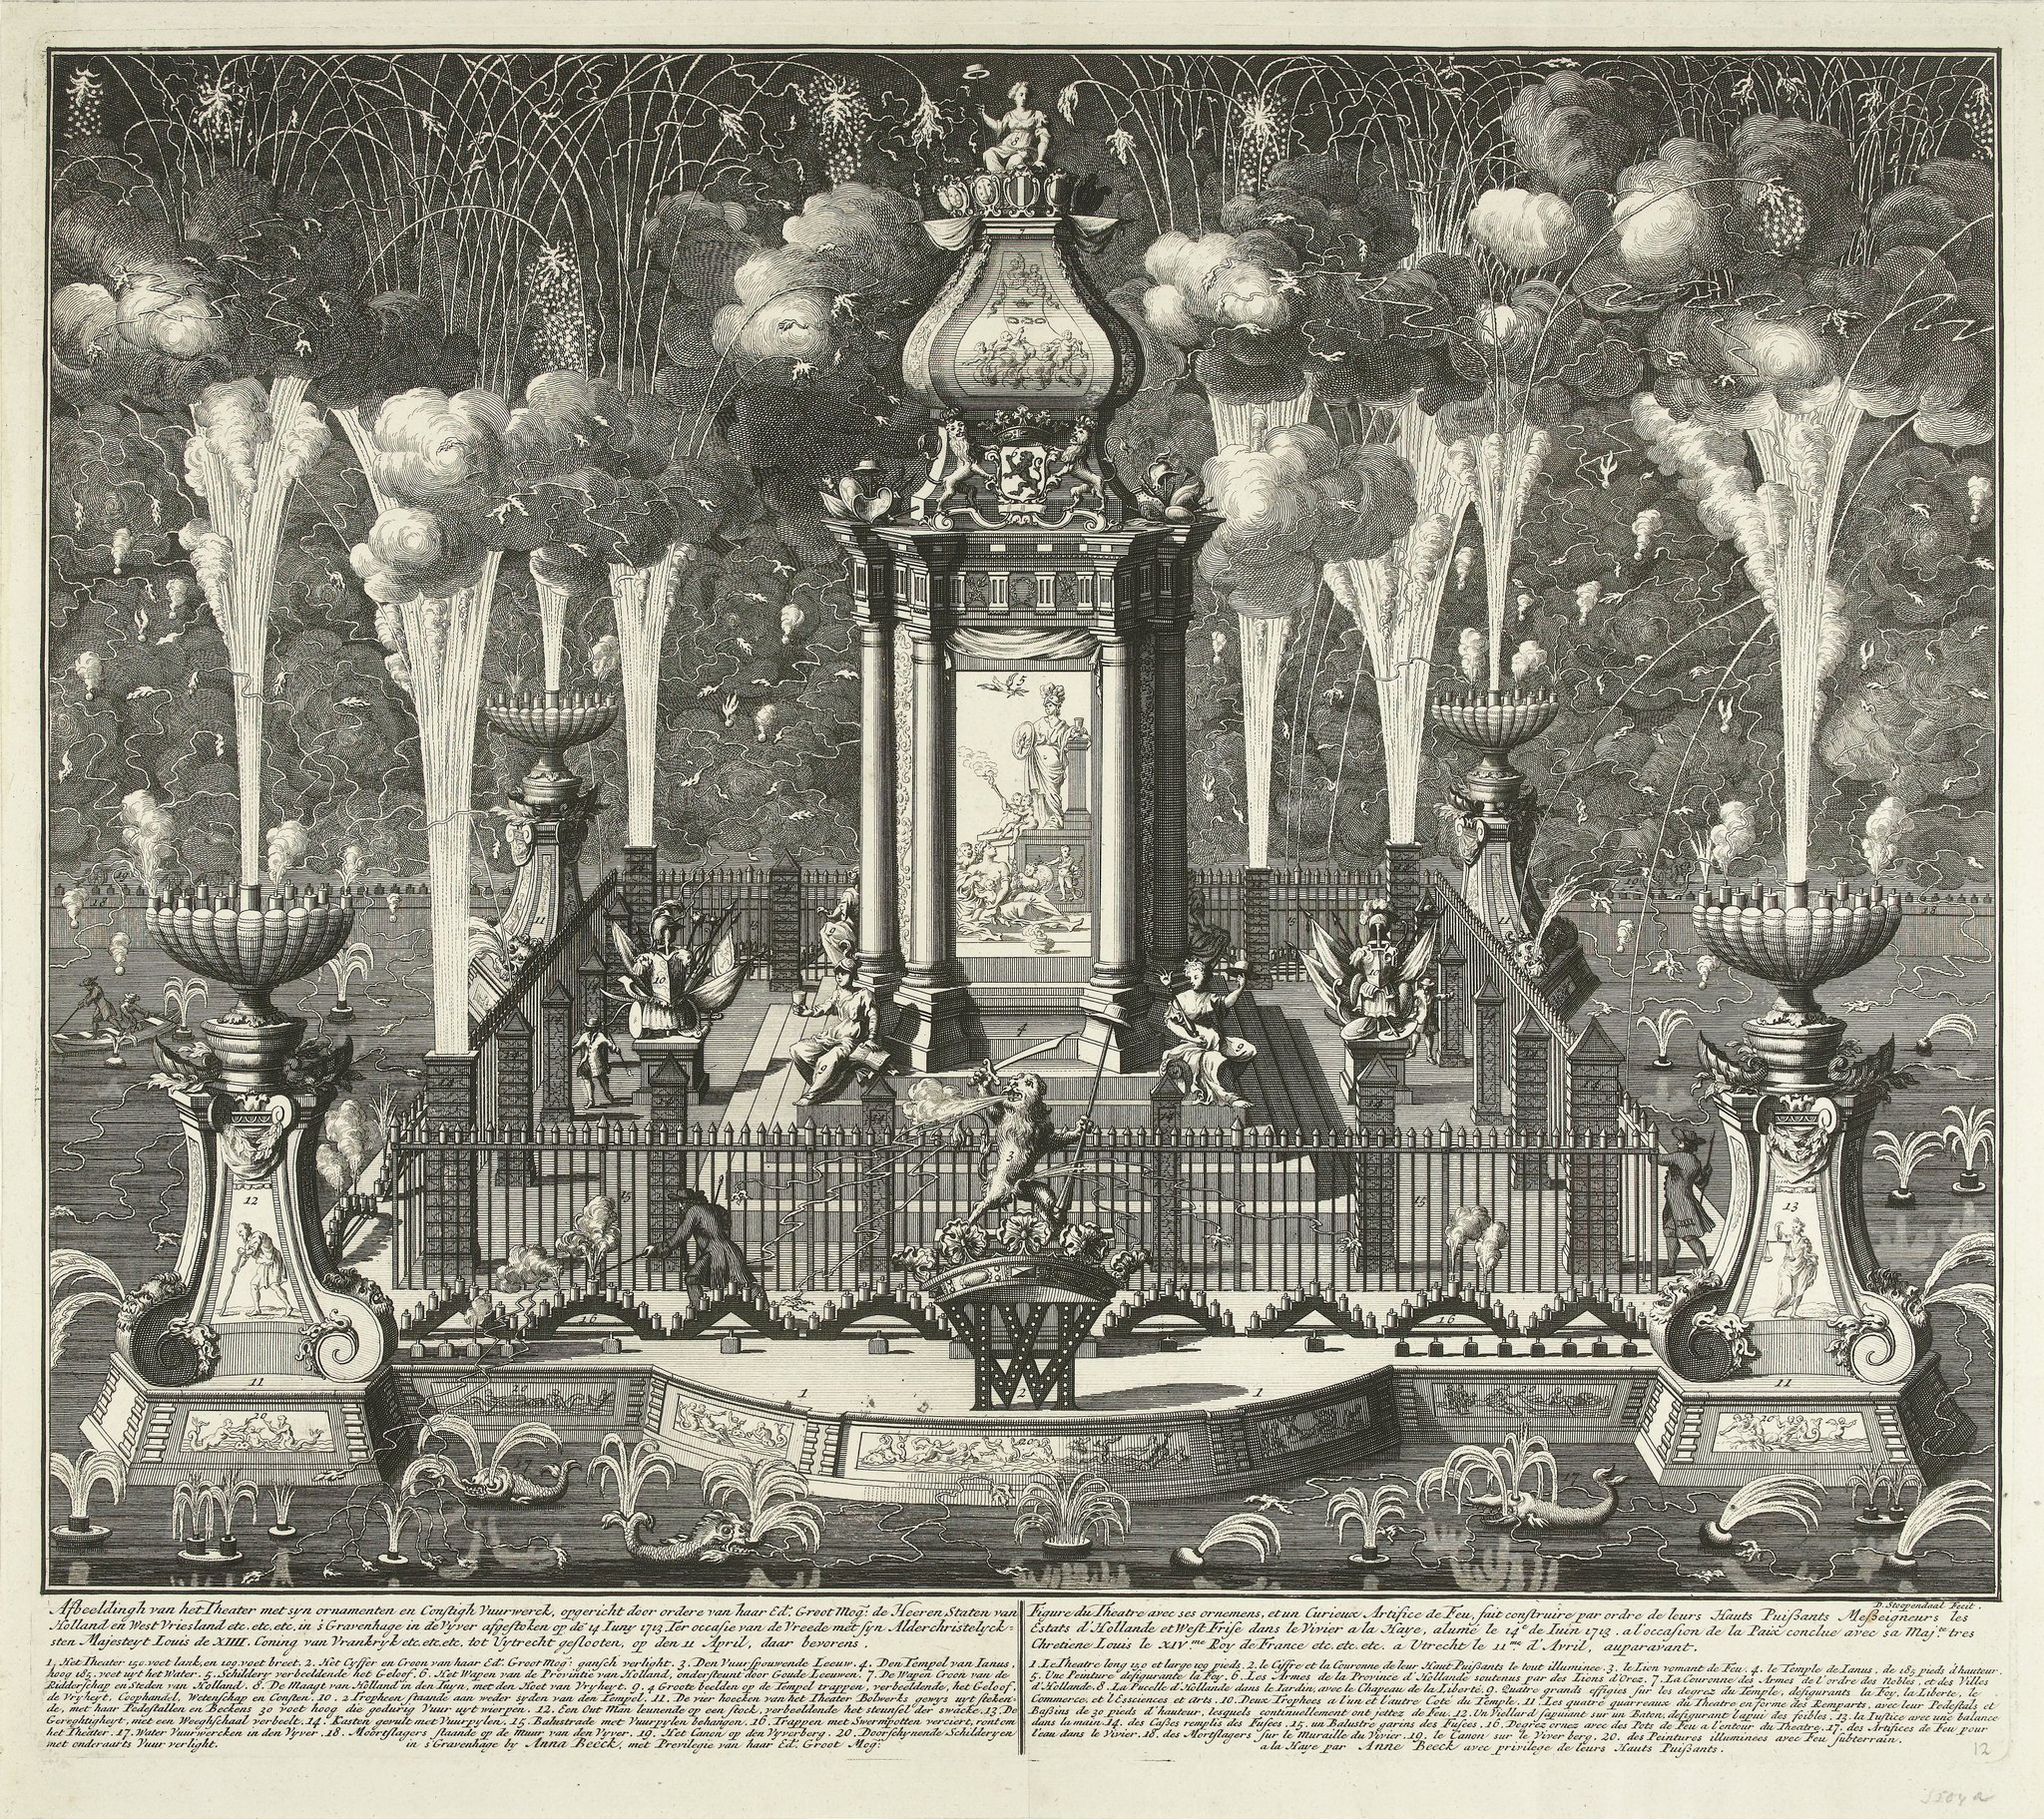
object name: print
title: Vuurwerk bij de viering van de Vrede van Utrecht, 1713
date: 1713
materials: paper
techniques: engraving, etching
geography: the hague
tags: festivities (+ illumination, fire-works ~ festive activities), bonfire, fire-works (+ illumination, fire-works ~ festive activities)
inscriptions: collector's mark: Lugt 2228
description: Stellage met vuurwerk afgestoken in opdracht van de Staten van Holland en West-Friesland op de Hofvijver te Den Haag bij de viering van de Vrede van Utrecht, 14 juni 1713. Centraal staat de tempel van Janus bekroond door de Hollandse Maagd met vrijheidshoed in de Hollandse Tuin. De tempel is omringd door zittende figuren van Geloof, Vrijheid, Koophandel, Wetenschap en de Kunsten. Op verschillende plaatsen zijn mannen bezig met het afsteken van het vuurwerk. Onderaan de titel en legenda 1-20 in het Nederlands en Frans.